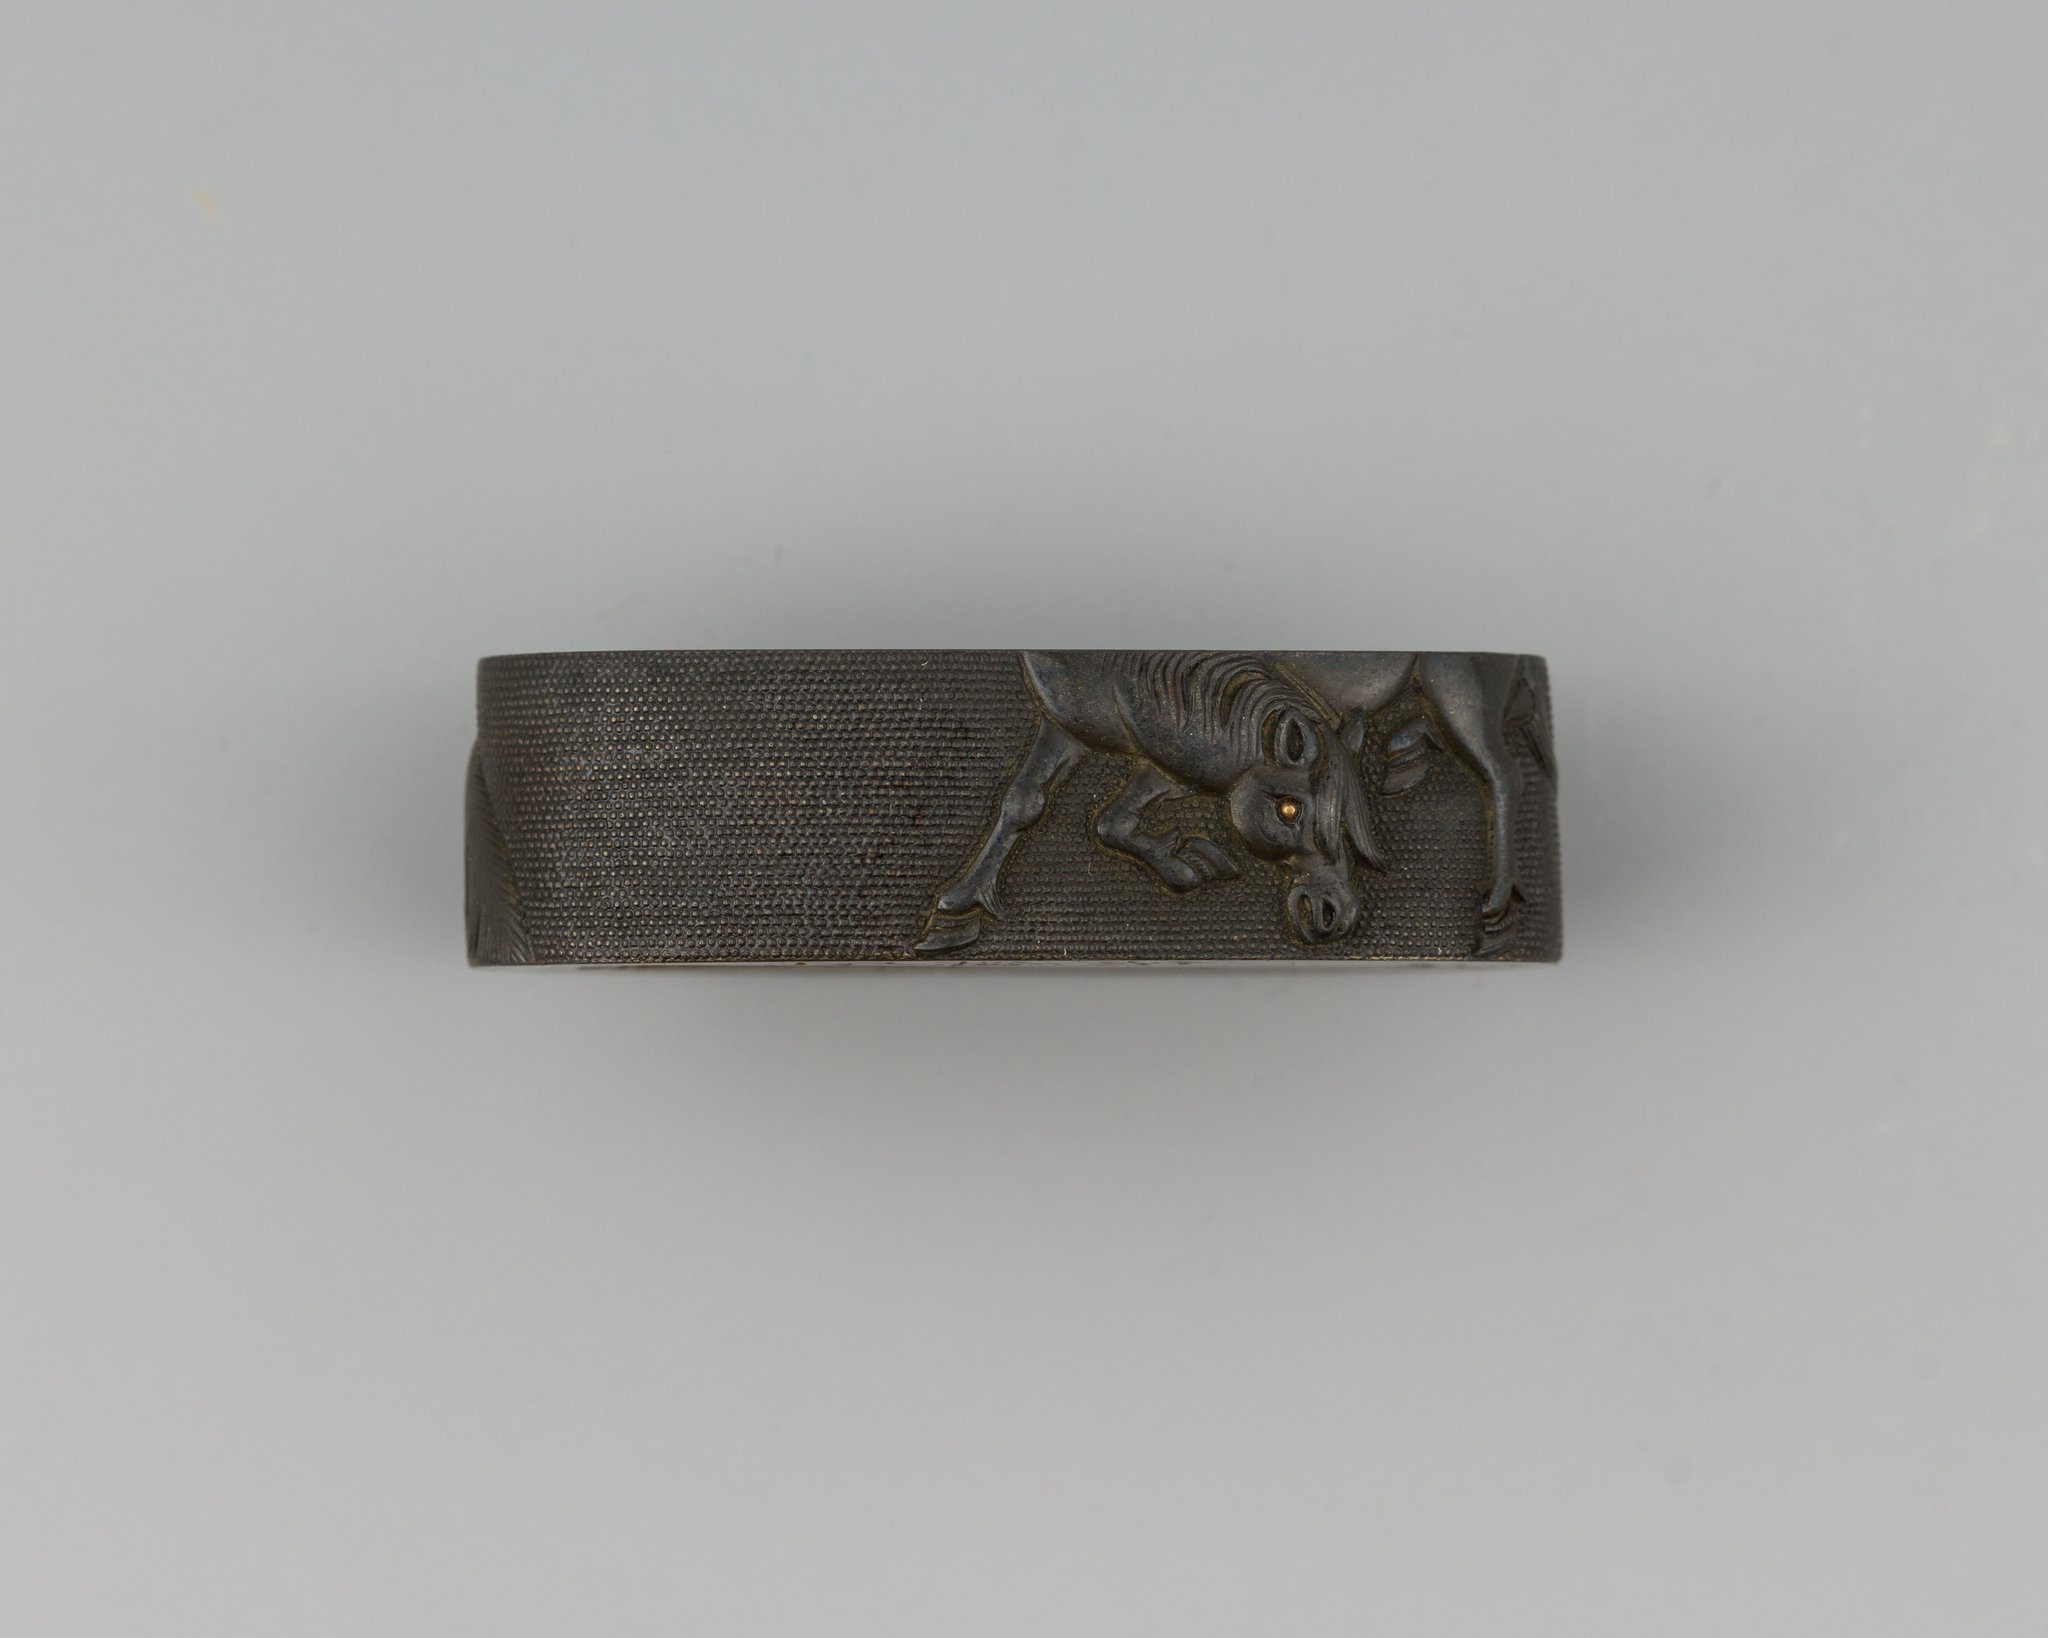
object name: sword hilt collar fuchi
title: Sword-Hilt Collar (Fuchi)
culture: japanese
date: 1615-1868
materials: silver alloy, gold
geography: japan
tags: horses